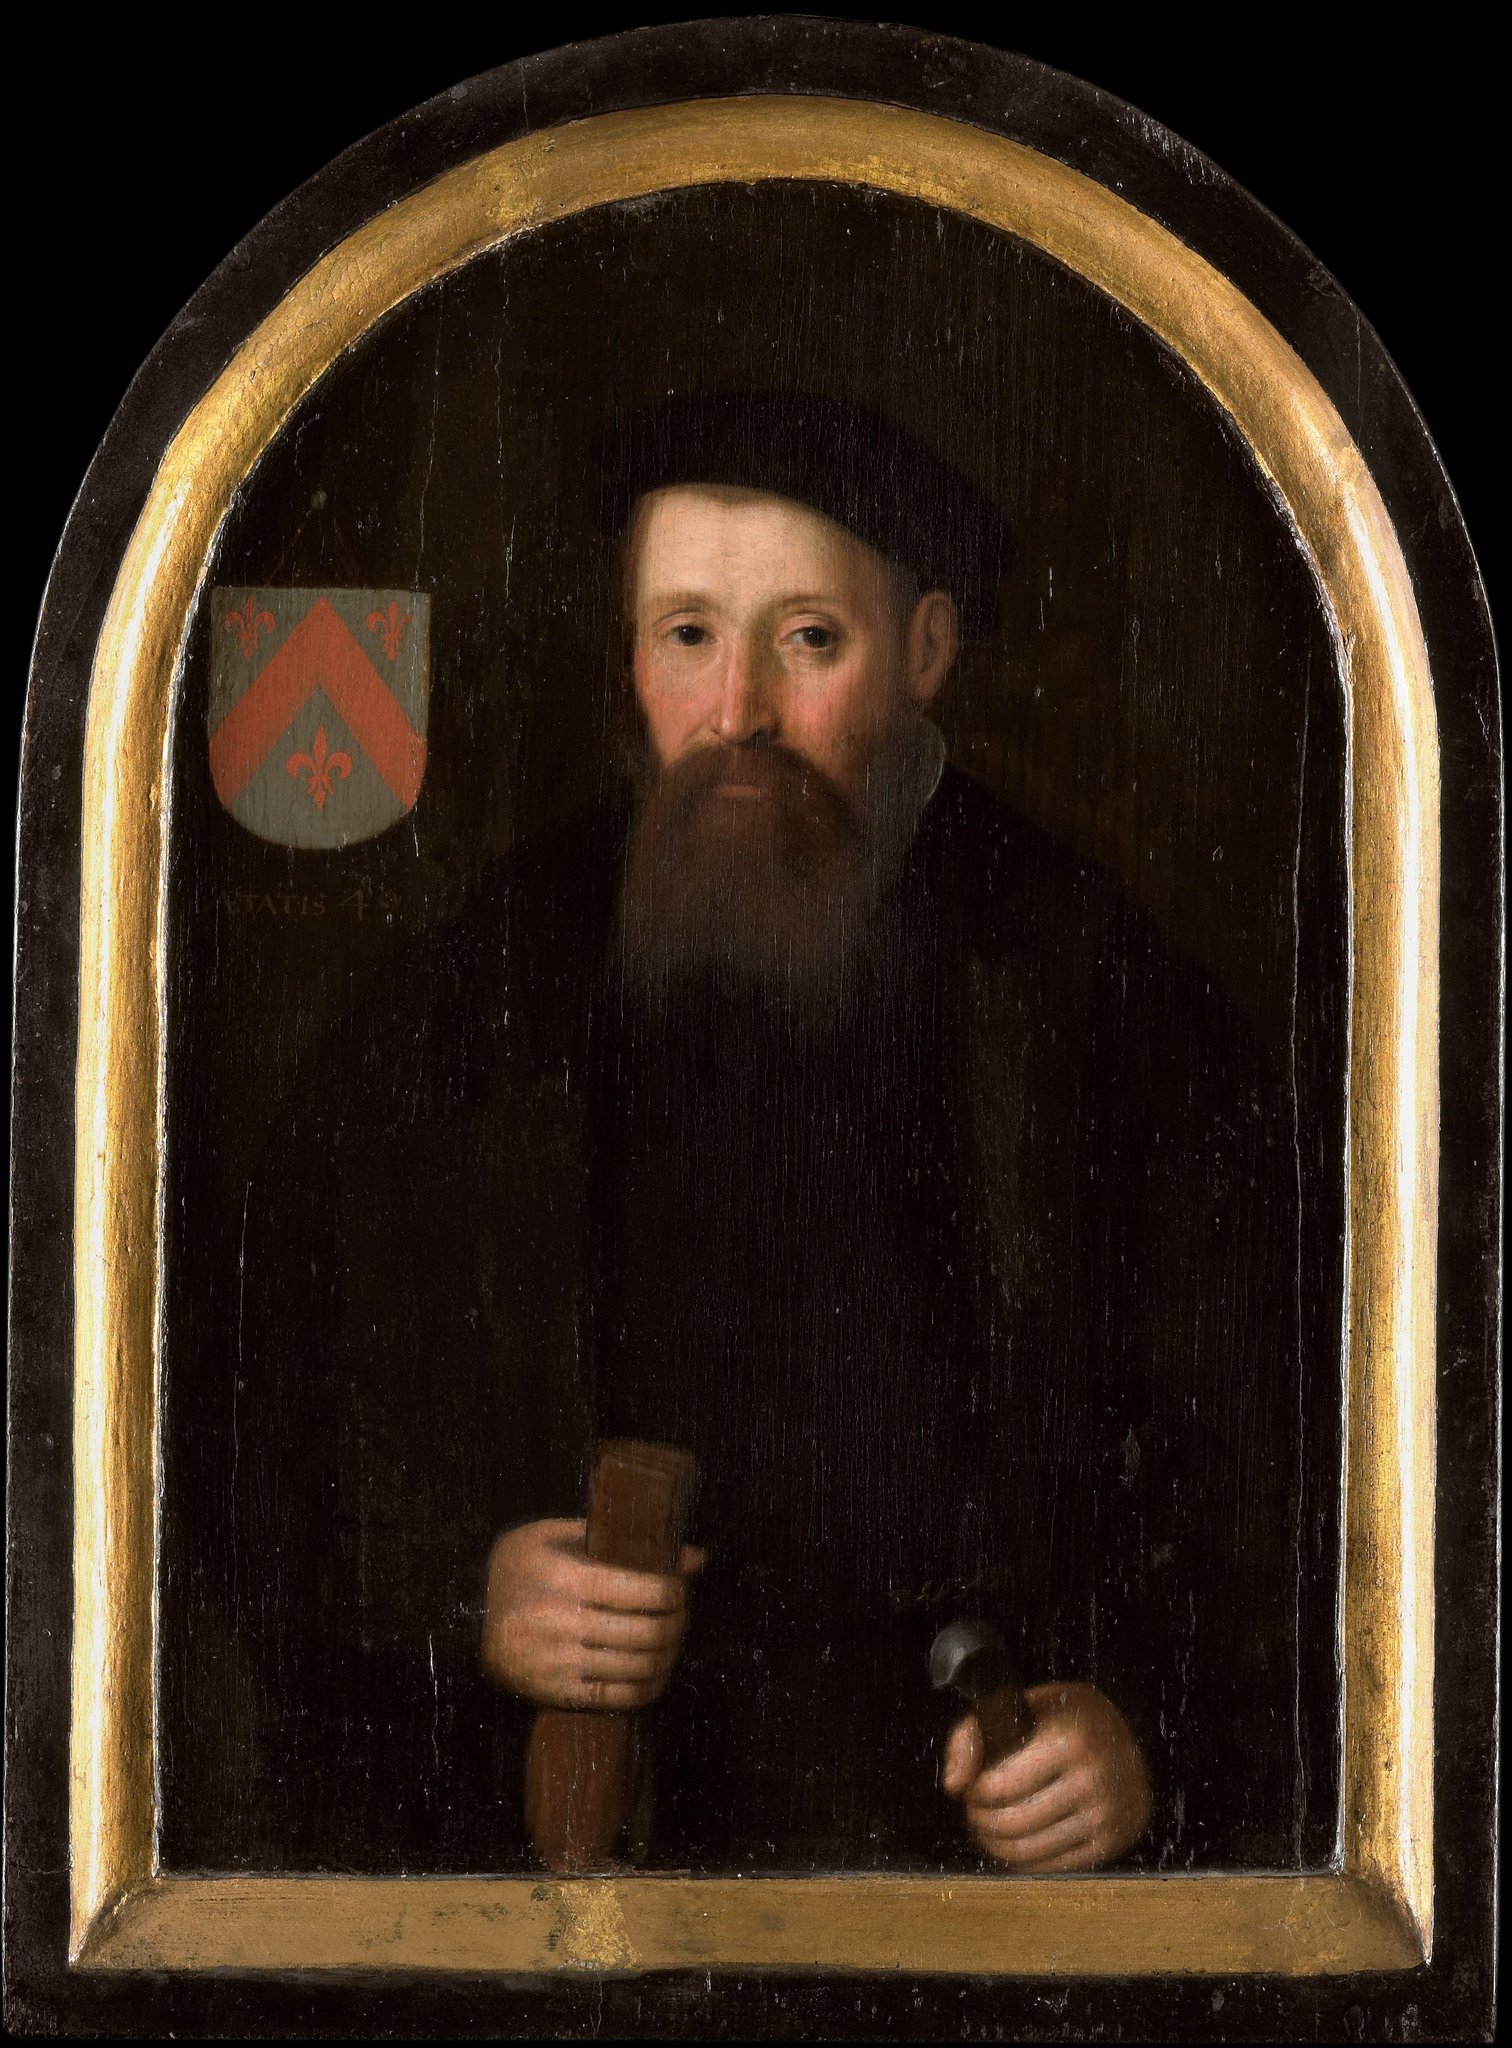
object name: painting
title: Portrait of Willem Fransz van Schoterbosch (c. 1510-?)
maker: cornelis engelsz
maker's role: painter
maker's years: 1574-1650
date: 1620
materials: oil, panel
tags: historical persons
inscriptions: coat of arms, upper left: a red chevron and three red fleurs-de-lis on a silver ground, inscription, centre left: ‘ÆTATIS 40’, inscription, on the reverse, in black paint: ‘3 / Willem Overyn van Schoterbosch, geb 15[..]’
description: Portret van Willem Fransz Overrijn van Schoterbosch (geb. ca. 1510). Ten halven lijve, staand met handschoenen in de rechterhand, de linkerhand op het gevest van zijn zwaard. Linksboven het familiewapen. Misschien een kopie door Cornelis Engelsz. naar een onbekende origineel uit ca. 1560. Behoort tot een groep portretten: SK-A-4753 / SK-A-4754 / SK-A-4776 / SK-A-4772 / SK-A-4771 / SK-A-4756 / SK-A-4757 / SK-A-4773 / SK-A-4758 / SK-A-4759 / SK-A-4775 en SK-A-4774.